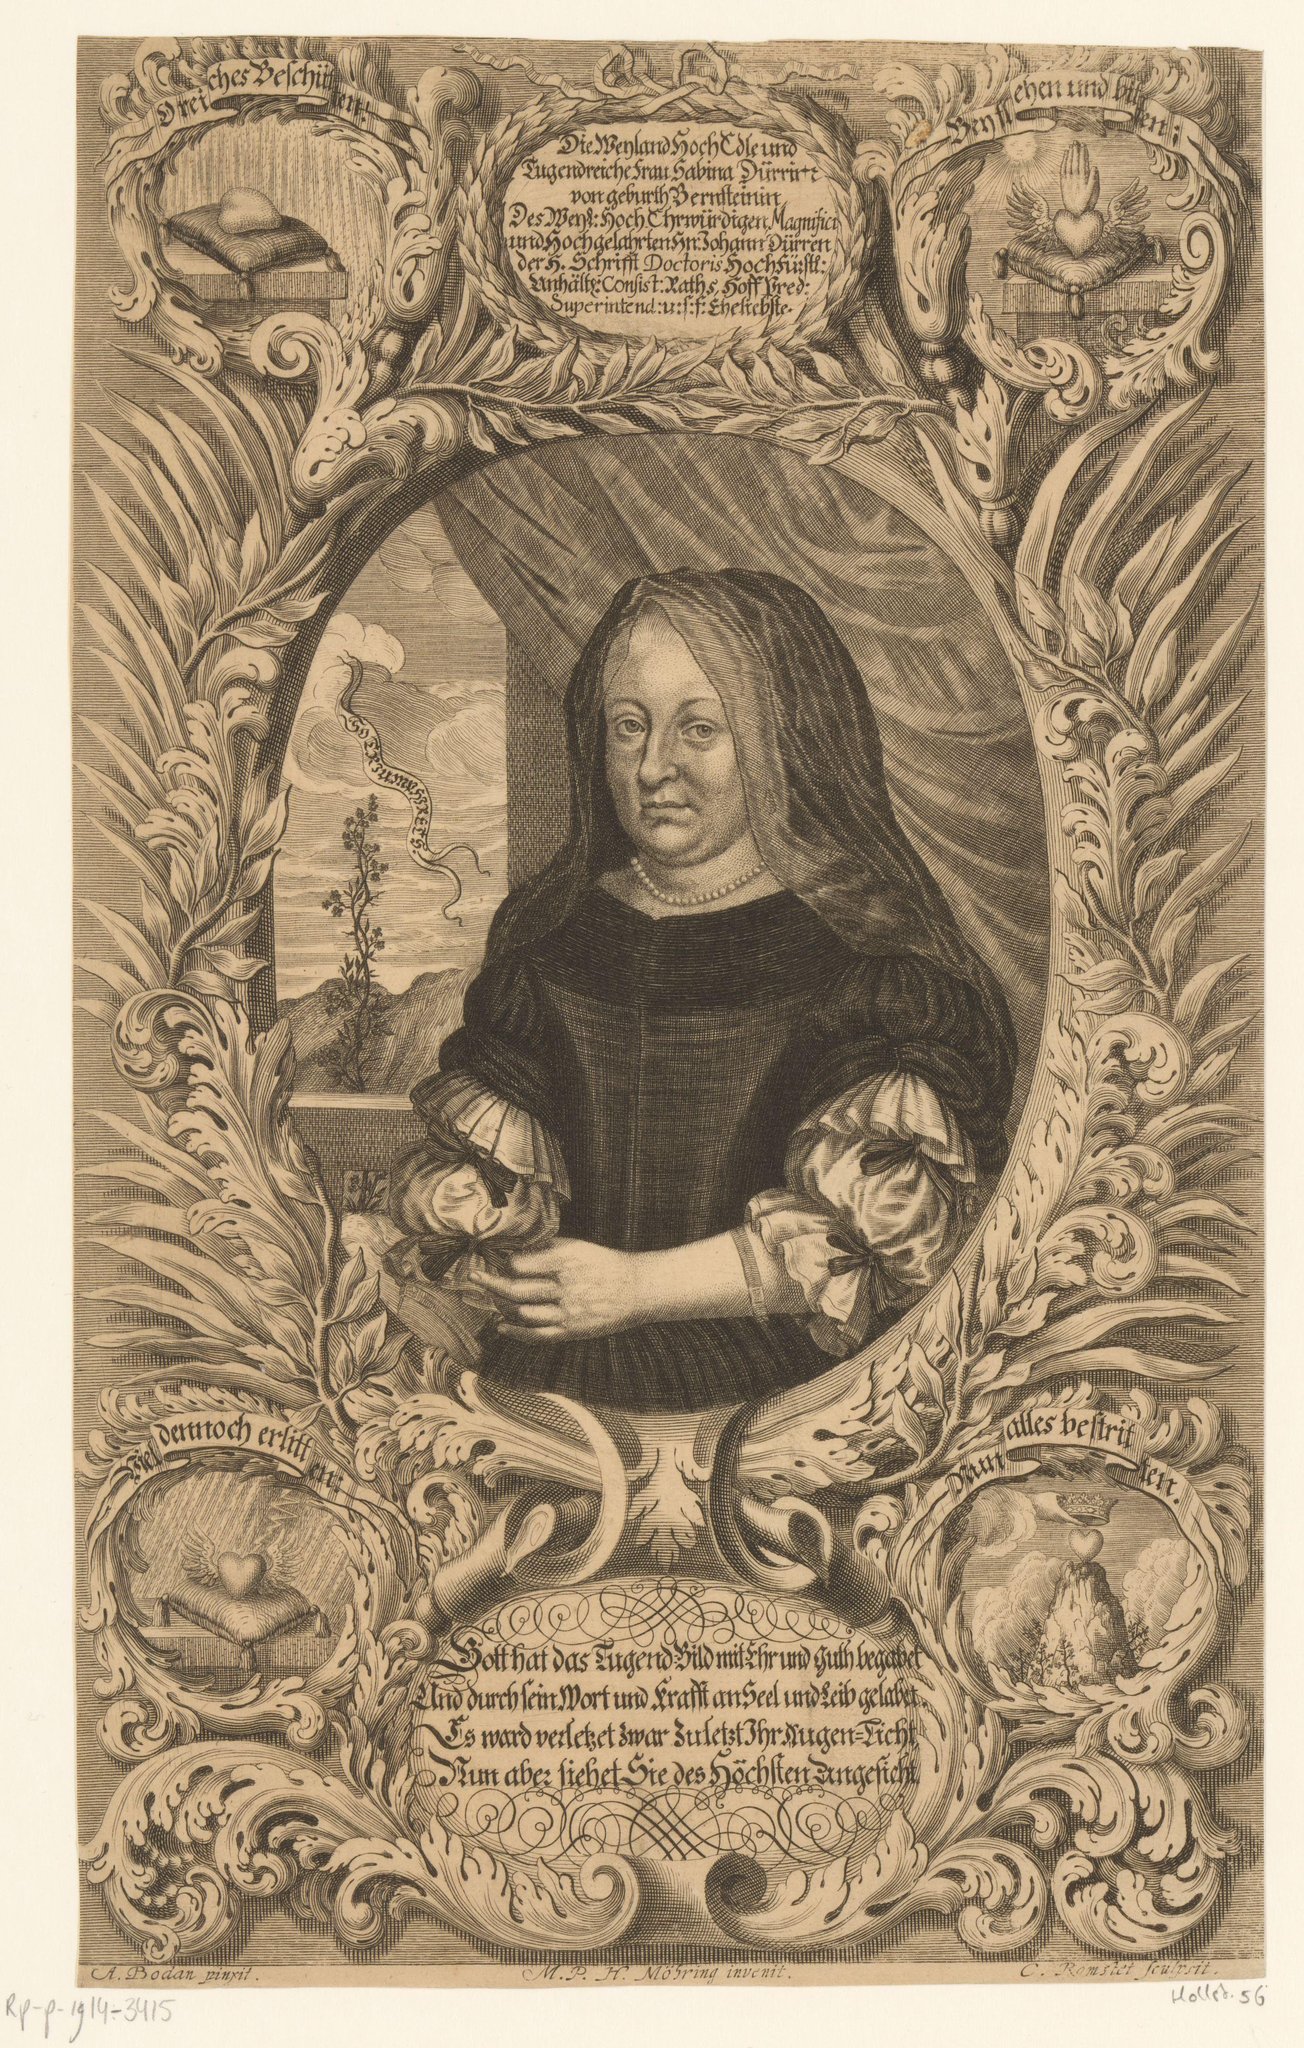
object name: print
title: Portret van Sabina Dürr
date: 1665-1721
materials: paper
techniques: engraving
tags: historical persons - bb - woman, pearl; pearl necklace, abstract ideas and concepts (+ emblematical representation of concept)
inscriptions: collector's mark: Lugt 2228